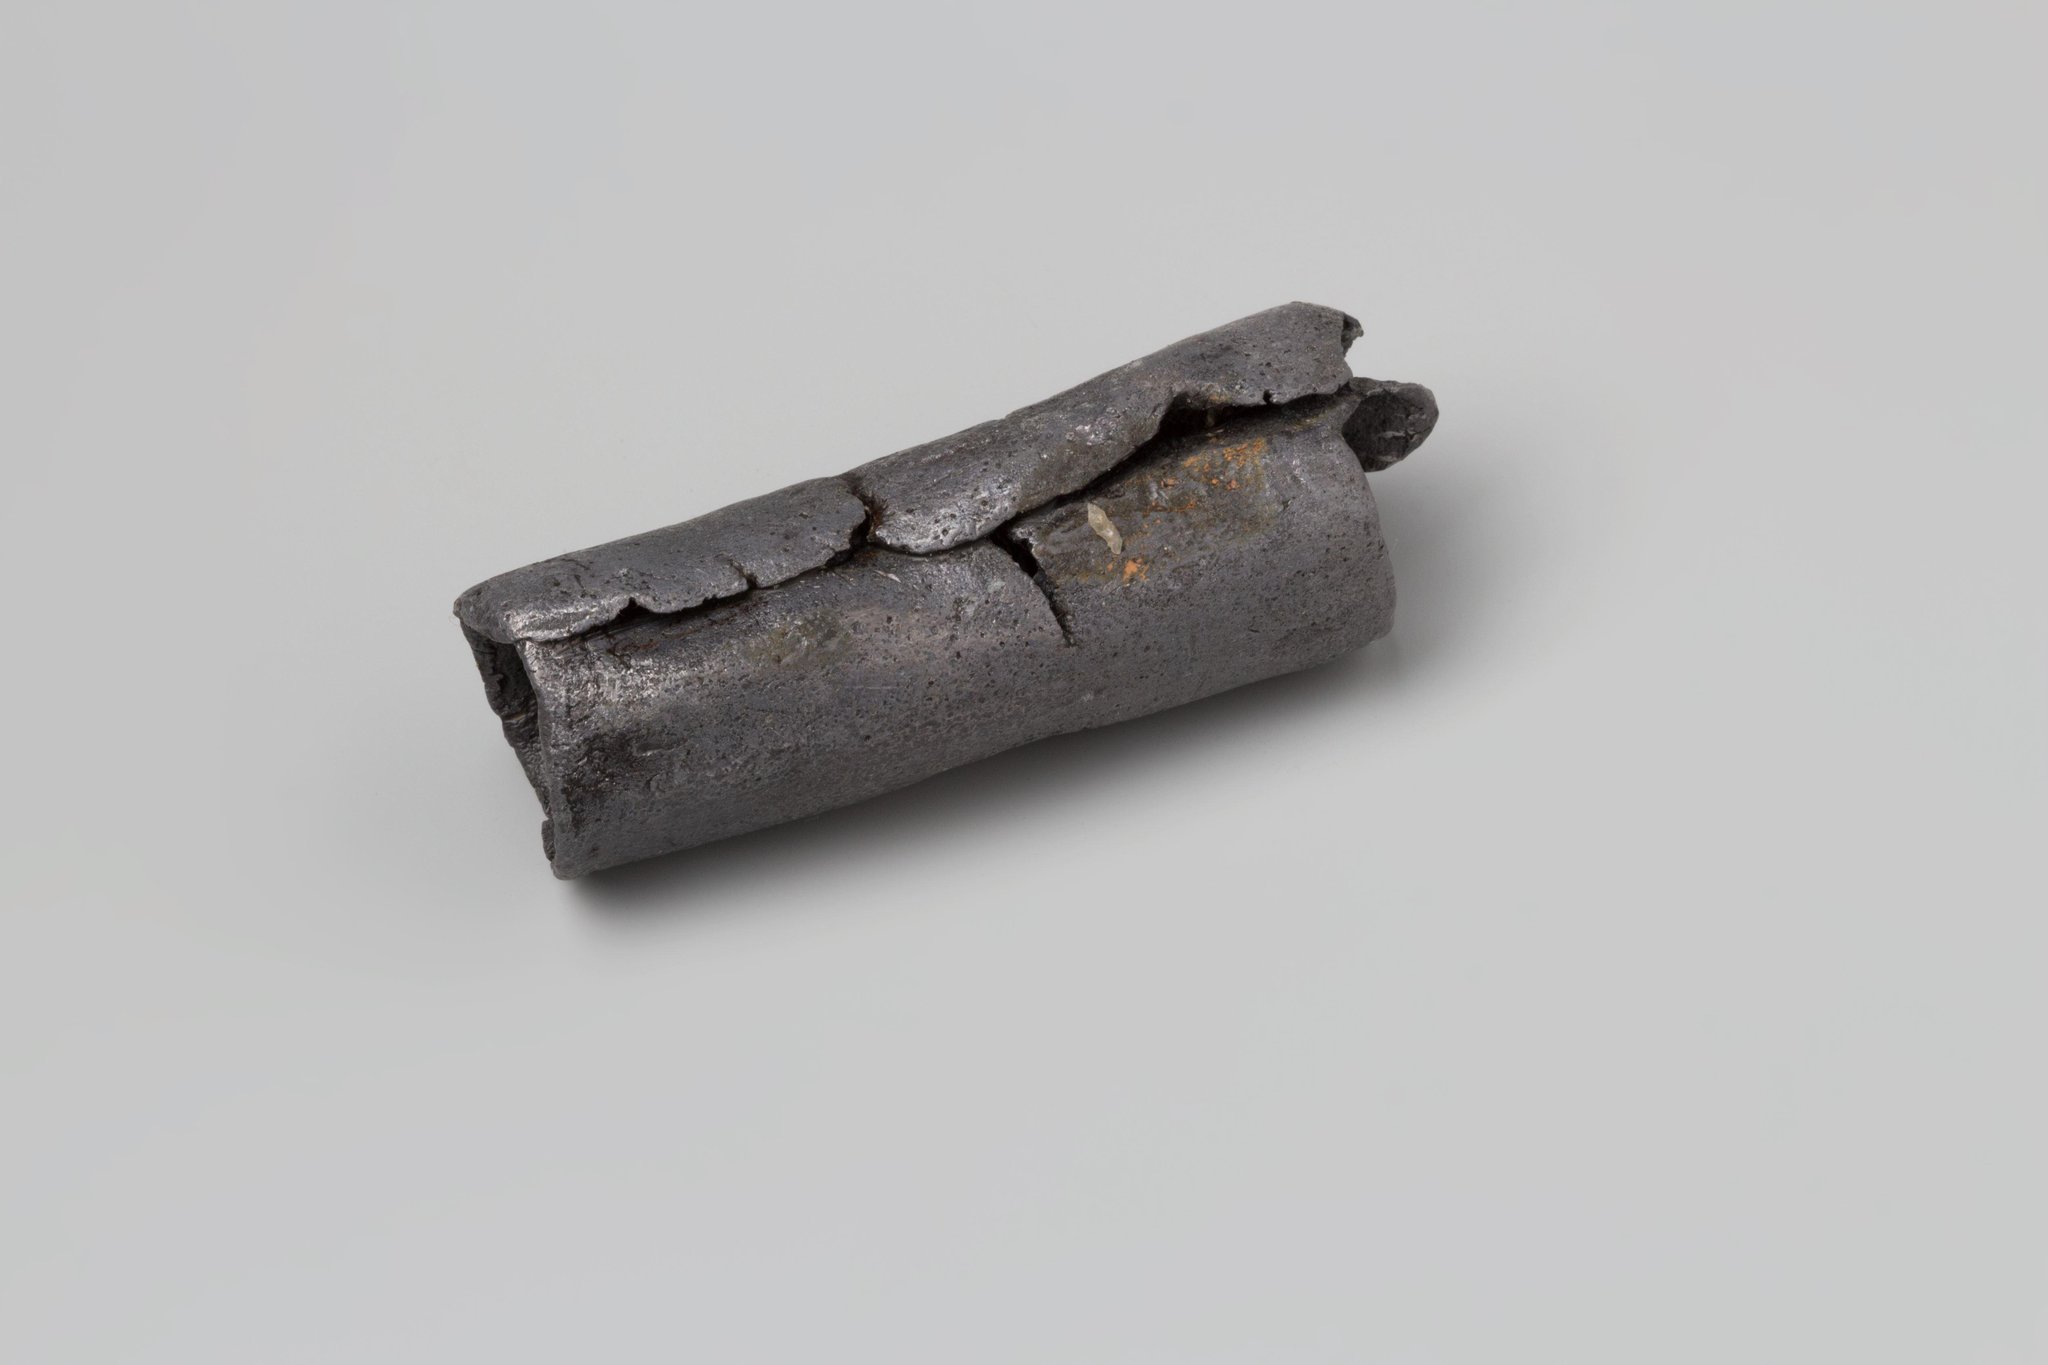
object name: lead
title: Loden rol uit het wrak van de Oost-Indiëvaarder 't Vliegend Hart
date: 1700-1735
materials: lead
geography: middelburg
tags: 't vliegend hart (schip), verenigde oostindische compagnie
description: Deze loden buisjes zijn vermoedelijk afkomstig van visnetten ofwel op TVliegend Hart zelf ofwel van vissers die hun netten aan het wrak verloren.